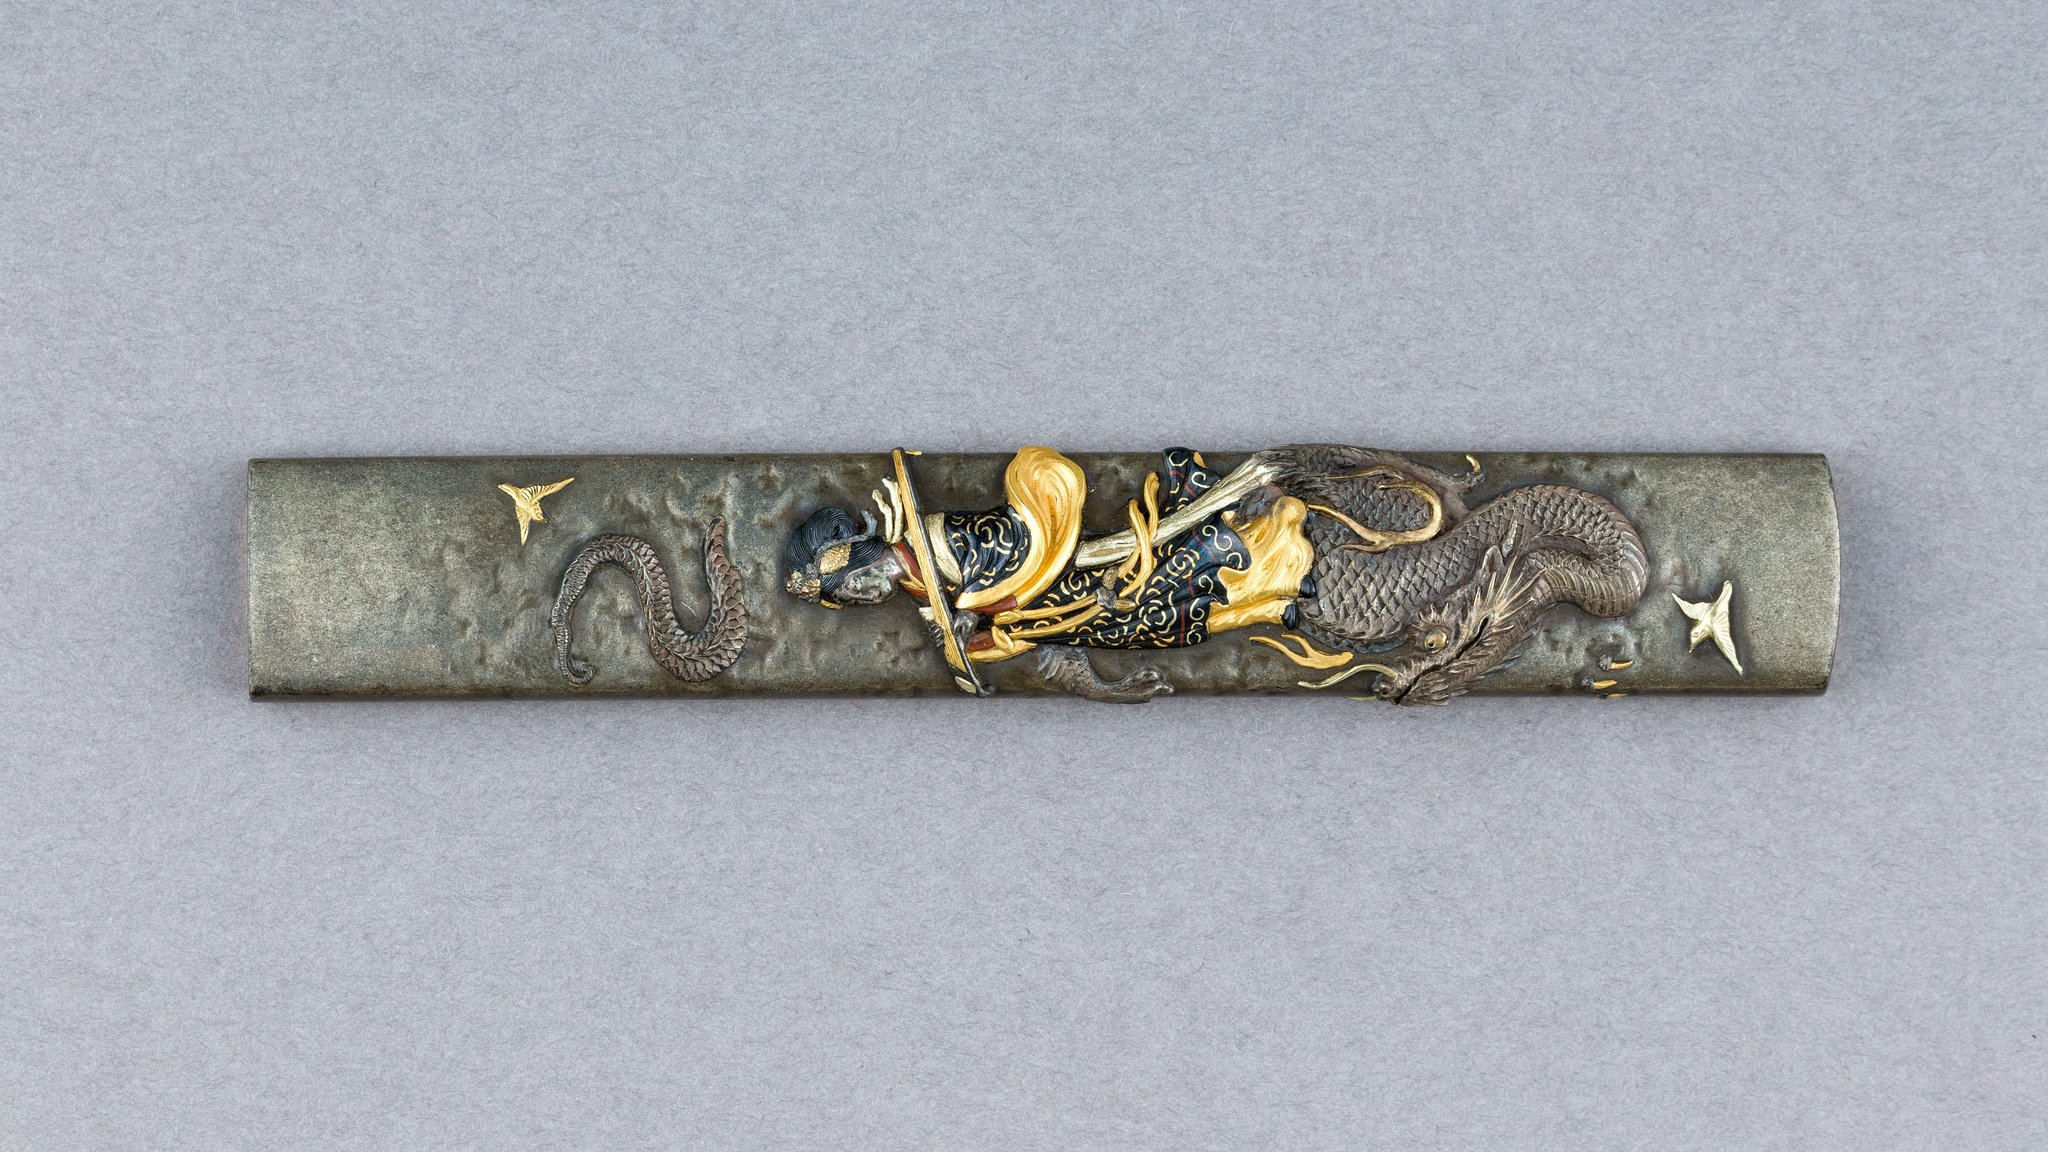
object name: knife handle kozuka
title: Knife Handle (Kozuka)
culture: japanese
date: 1615-1868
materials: gold alloy, silver alloy, gold, silver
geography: japan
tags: musical instruments,women,dragons